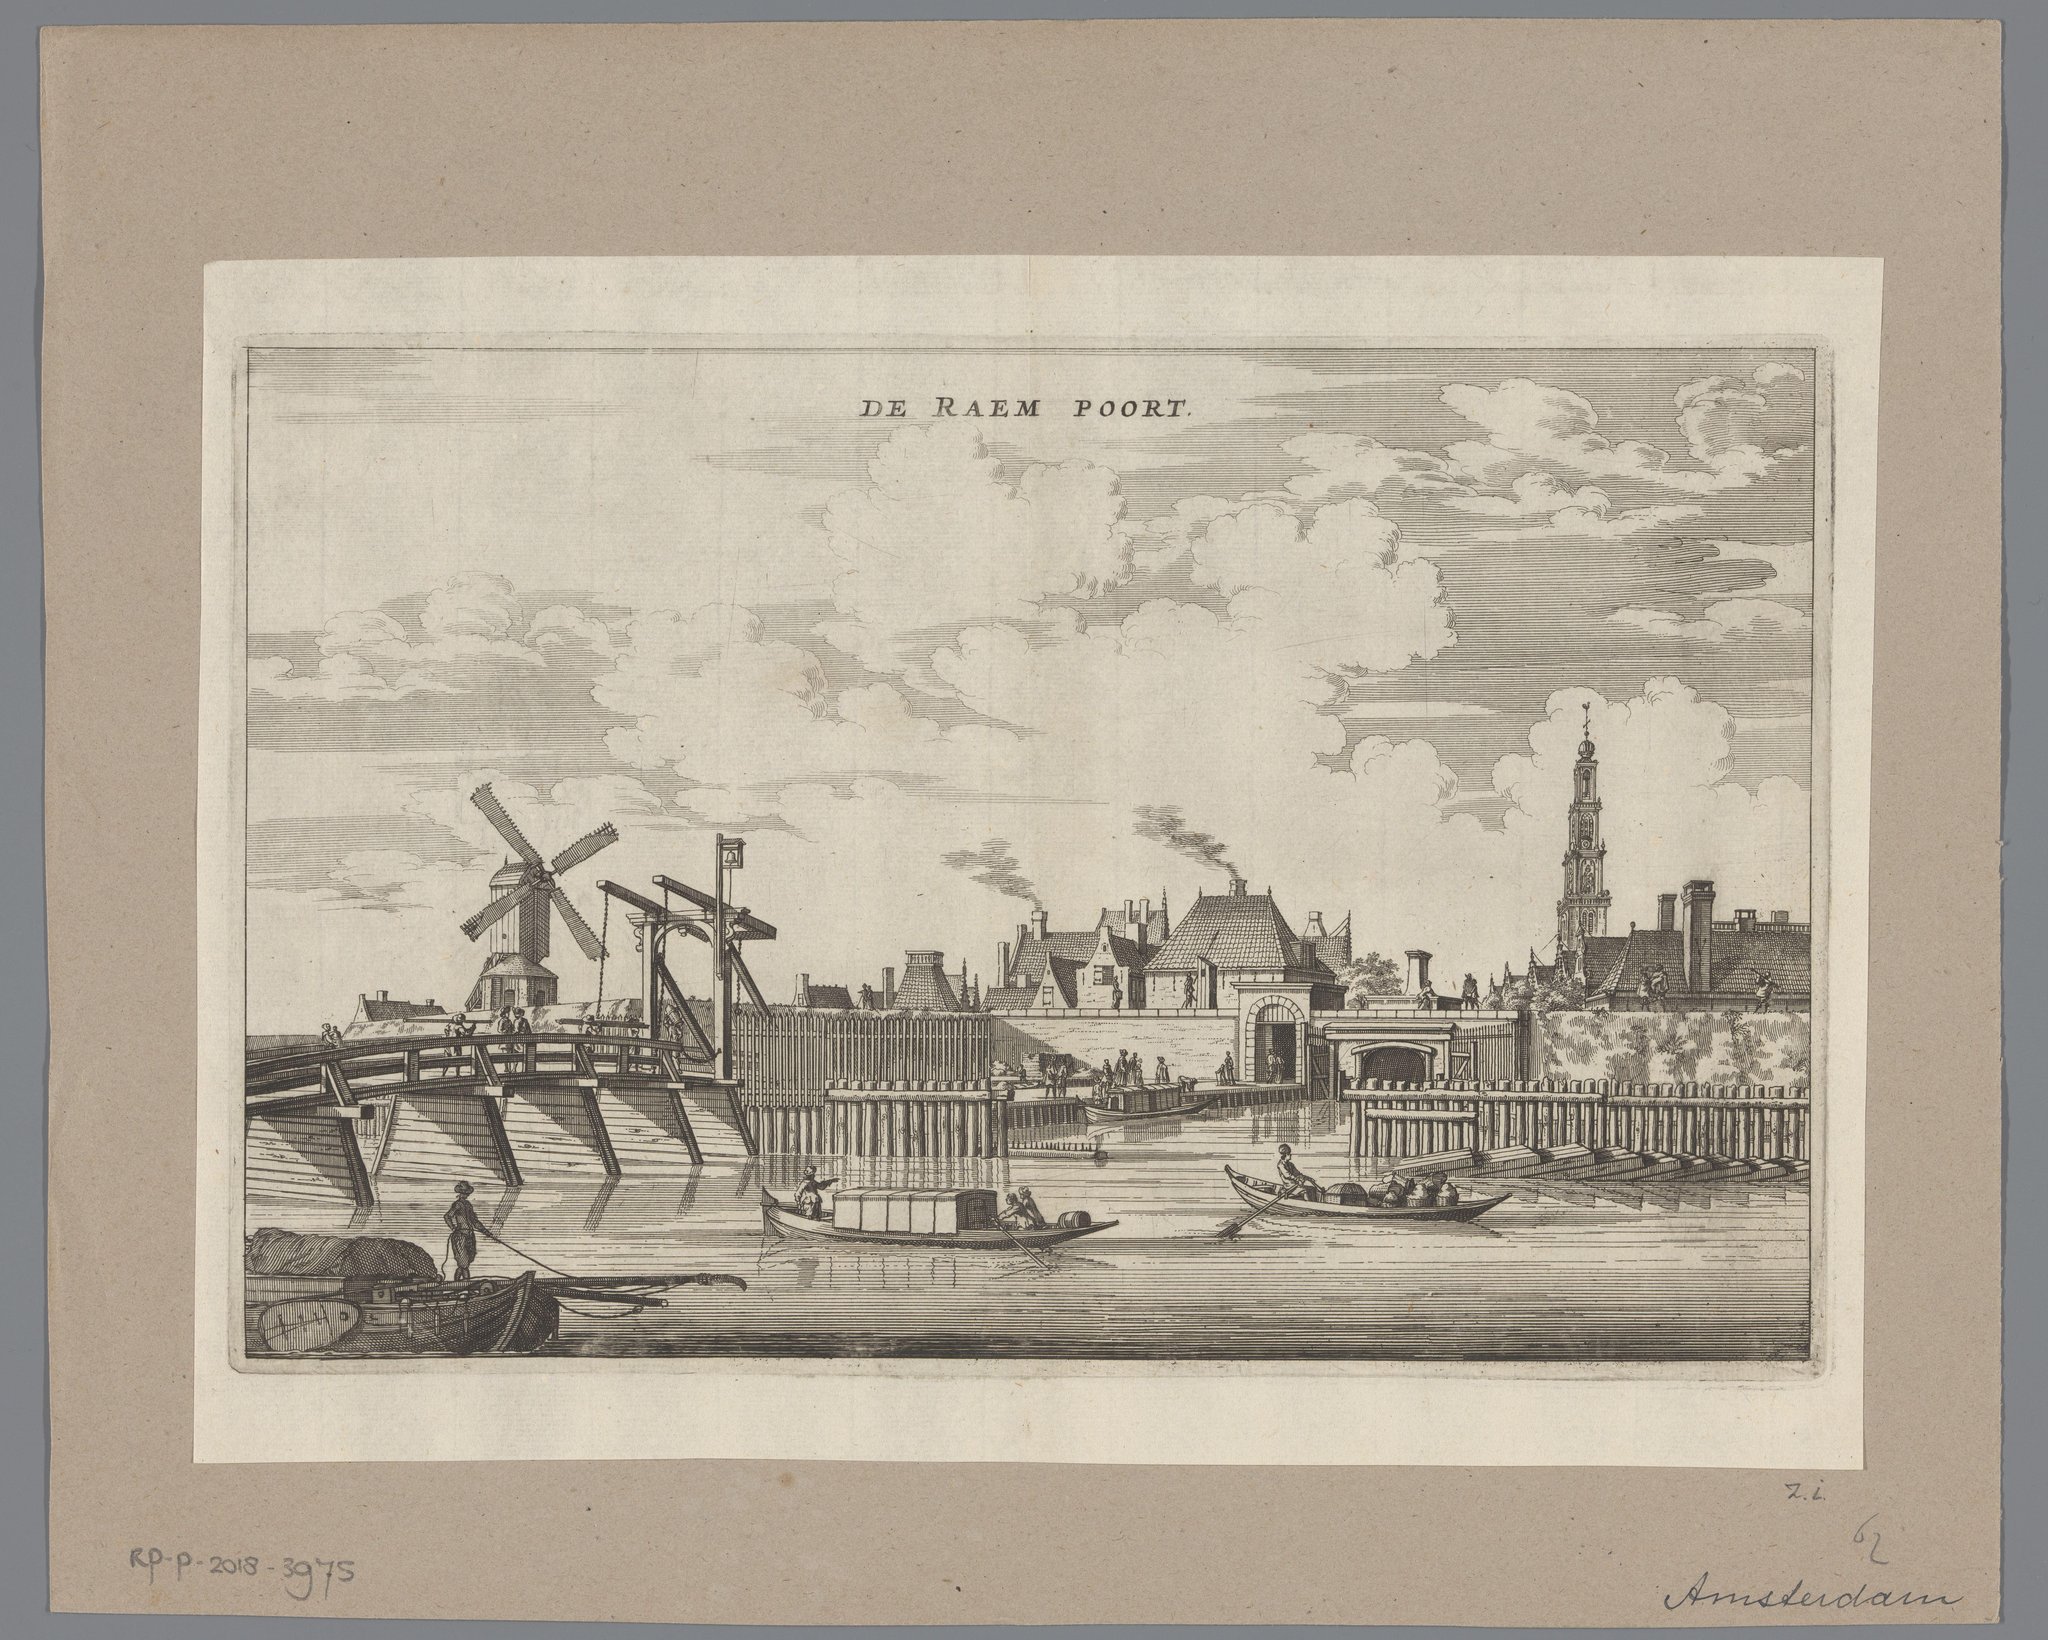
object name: print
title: Gezicht op de Raampoort in Amsterdam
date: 1663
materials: paper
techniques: engraving, etching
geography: amsterdam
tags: rowing-boat, canoe, etc., windmill in landscape, parts of church exterior and annexes, bridge in city across river, canal, etc., city-gate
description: Prent uit: Dapper, Olfert. Historische beschryving der stadt Amsterdam (...). Amsterdam: Jacob van Meurs, 1663, tussen p. 452-453. Een identieke versie van de prent bestaat met een Frans opschrift boven het Nederlandse opschrift.